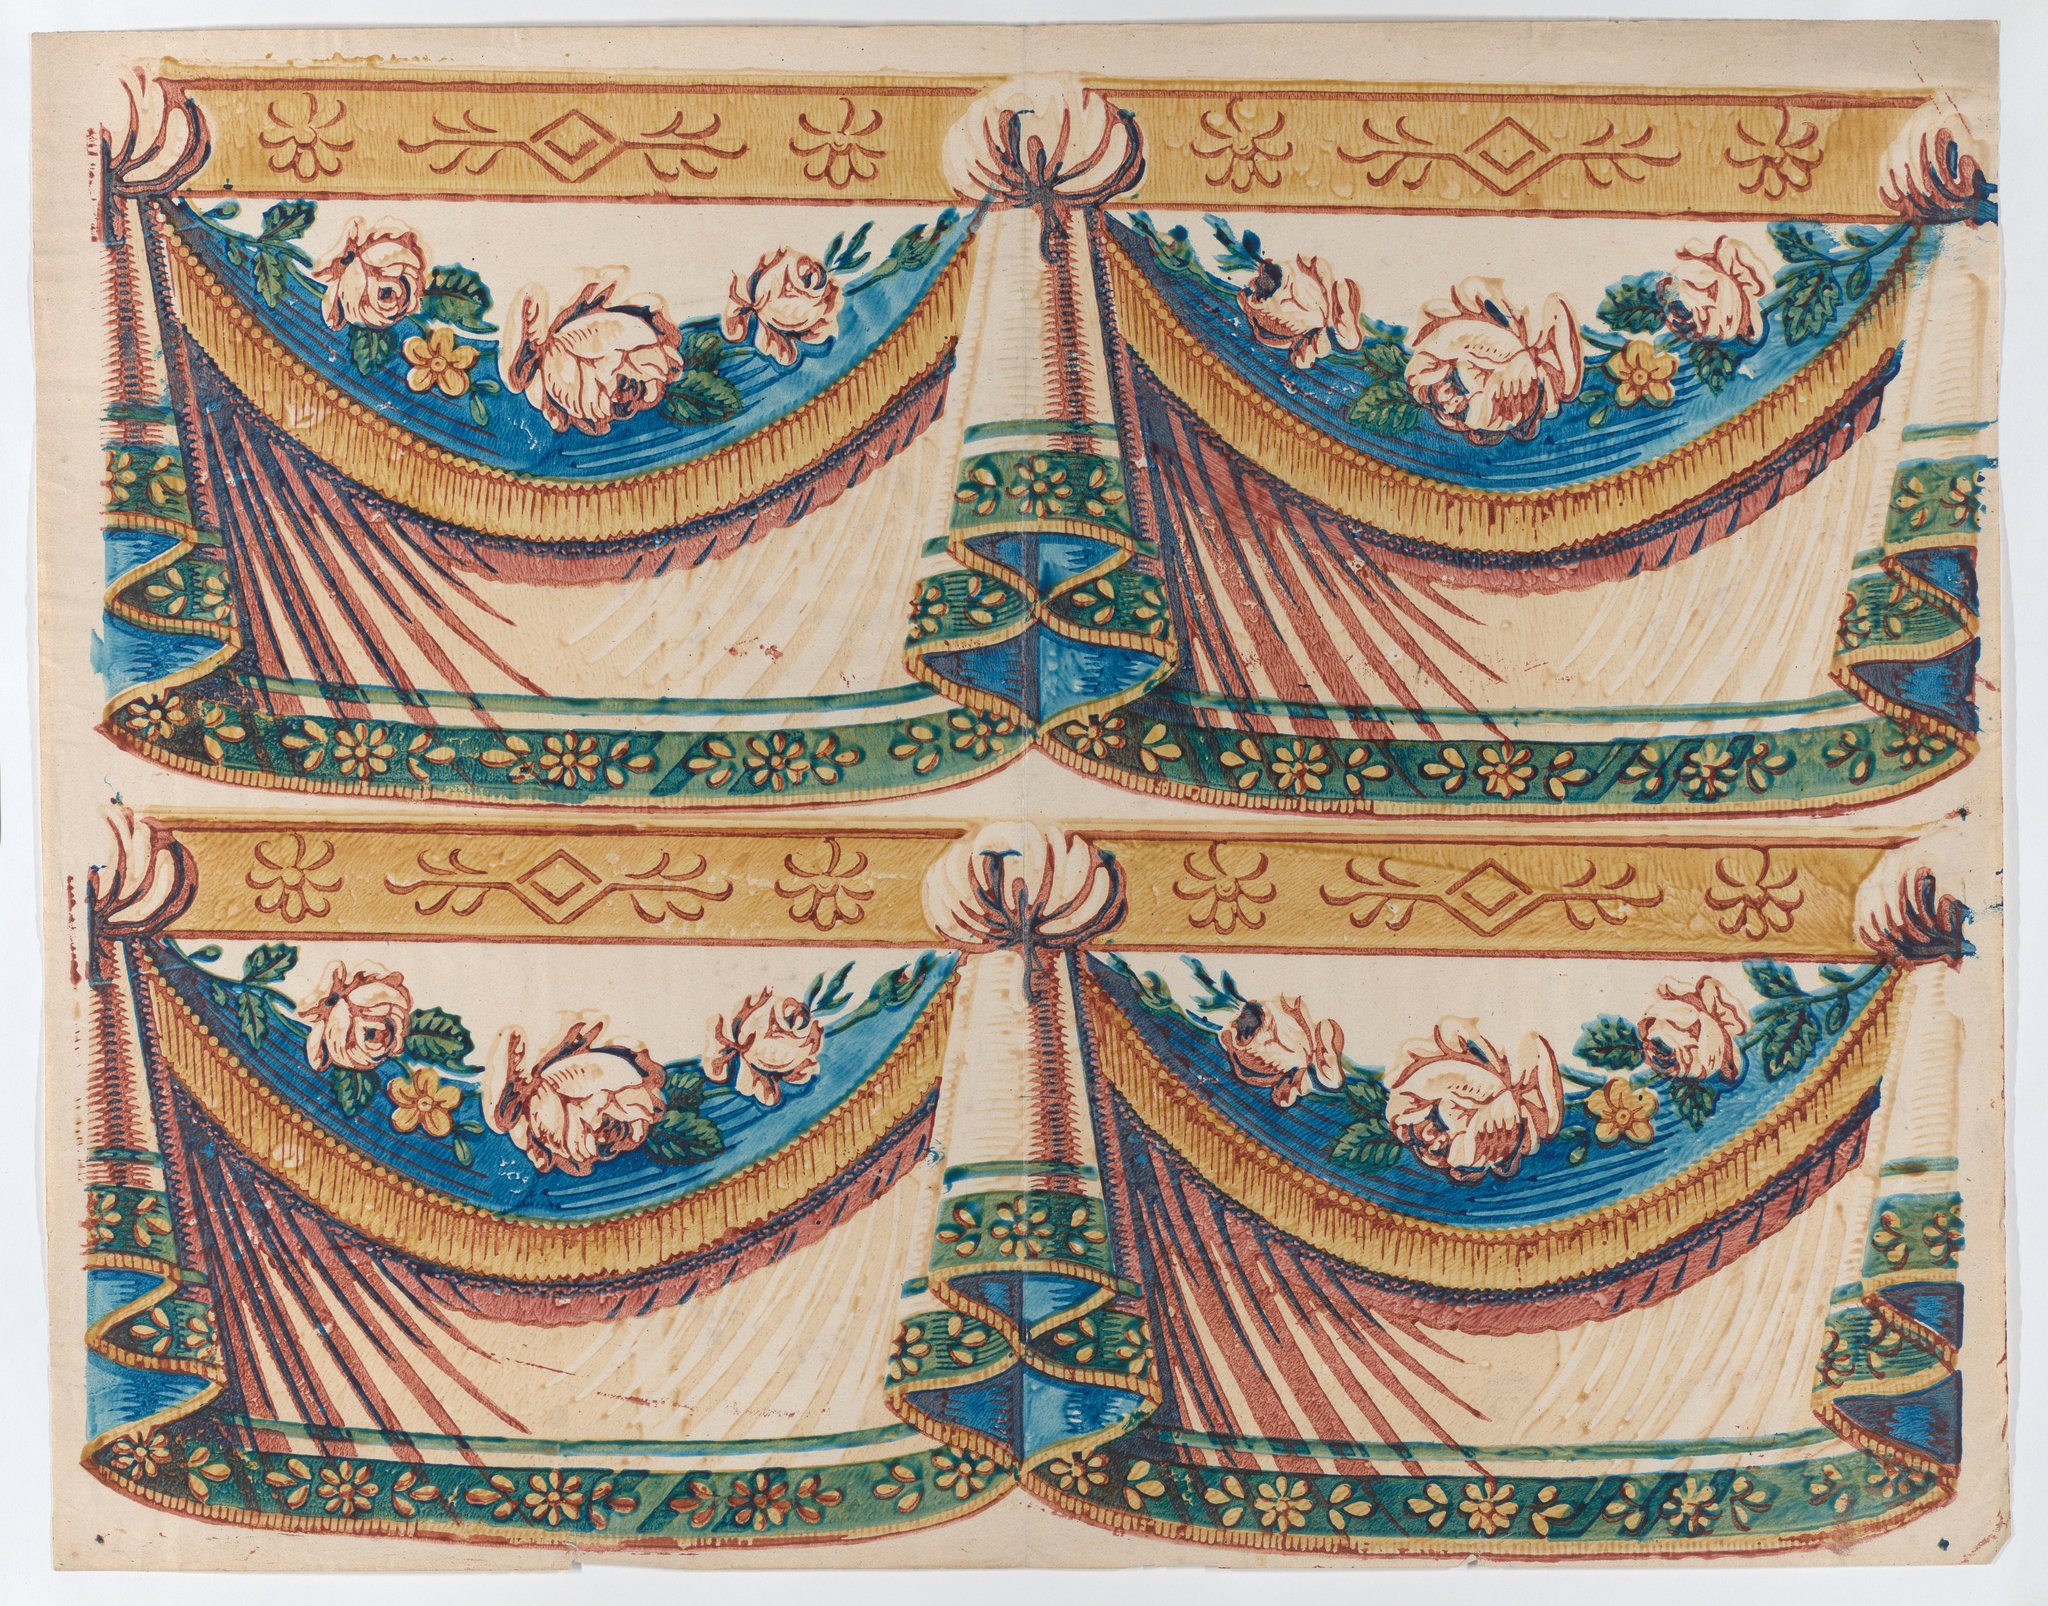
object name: print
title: Sheet with two borders with drapery and floral designs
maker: Anonymous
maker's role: artist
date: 1767-1866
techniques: relief print